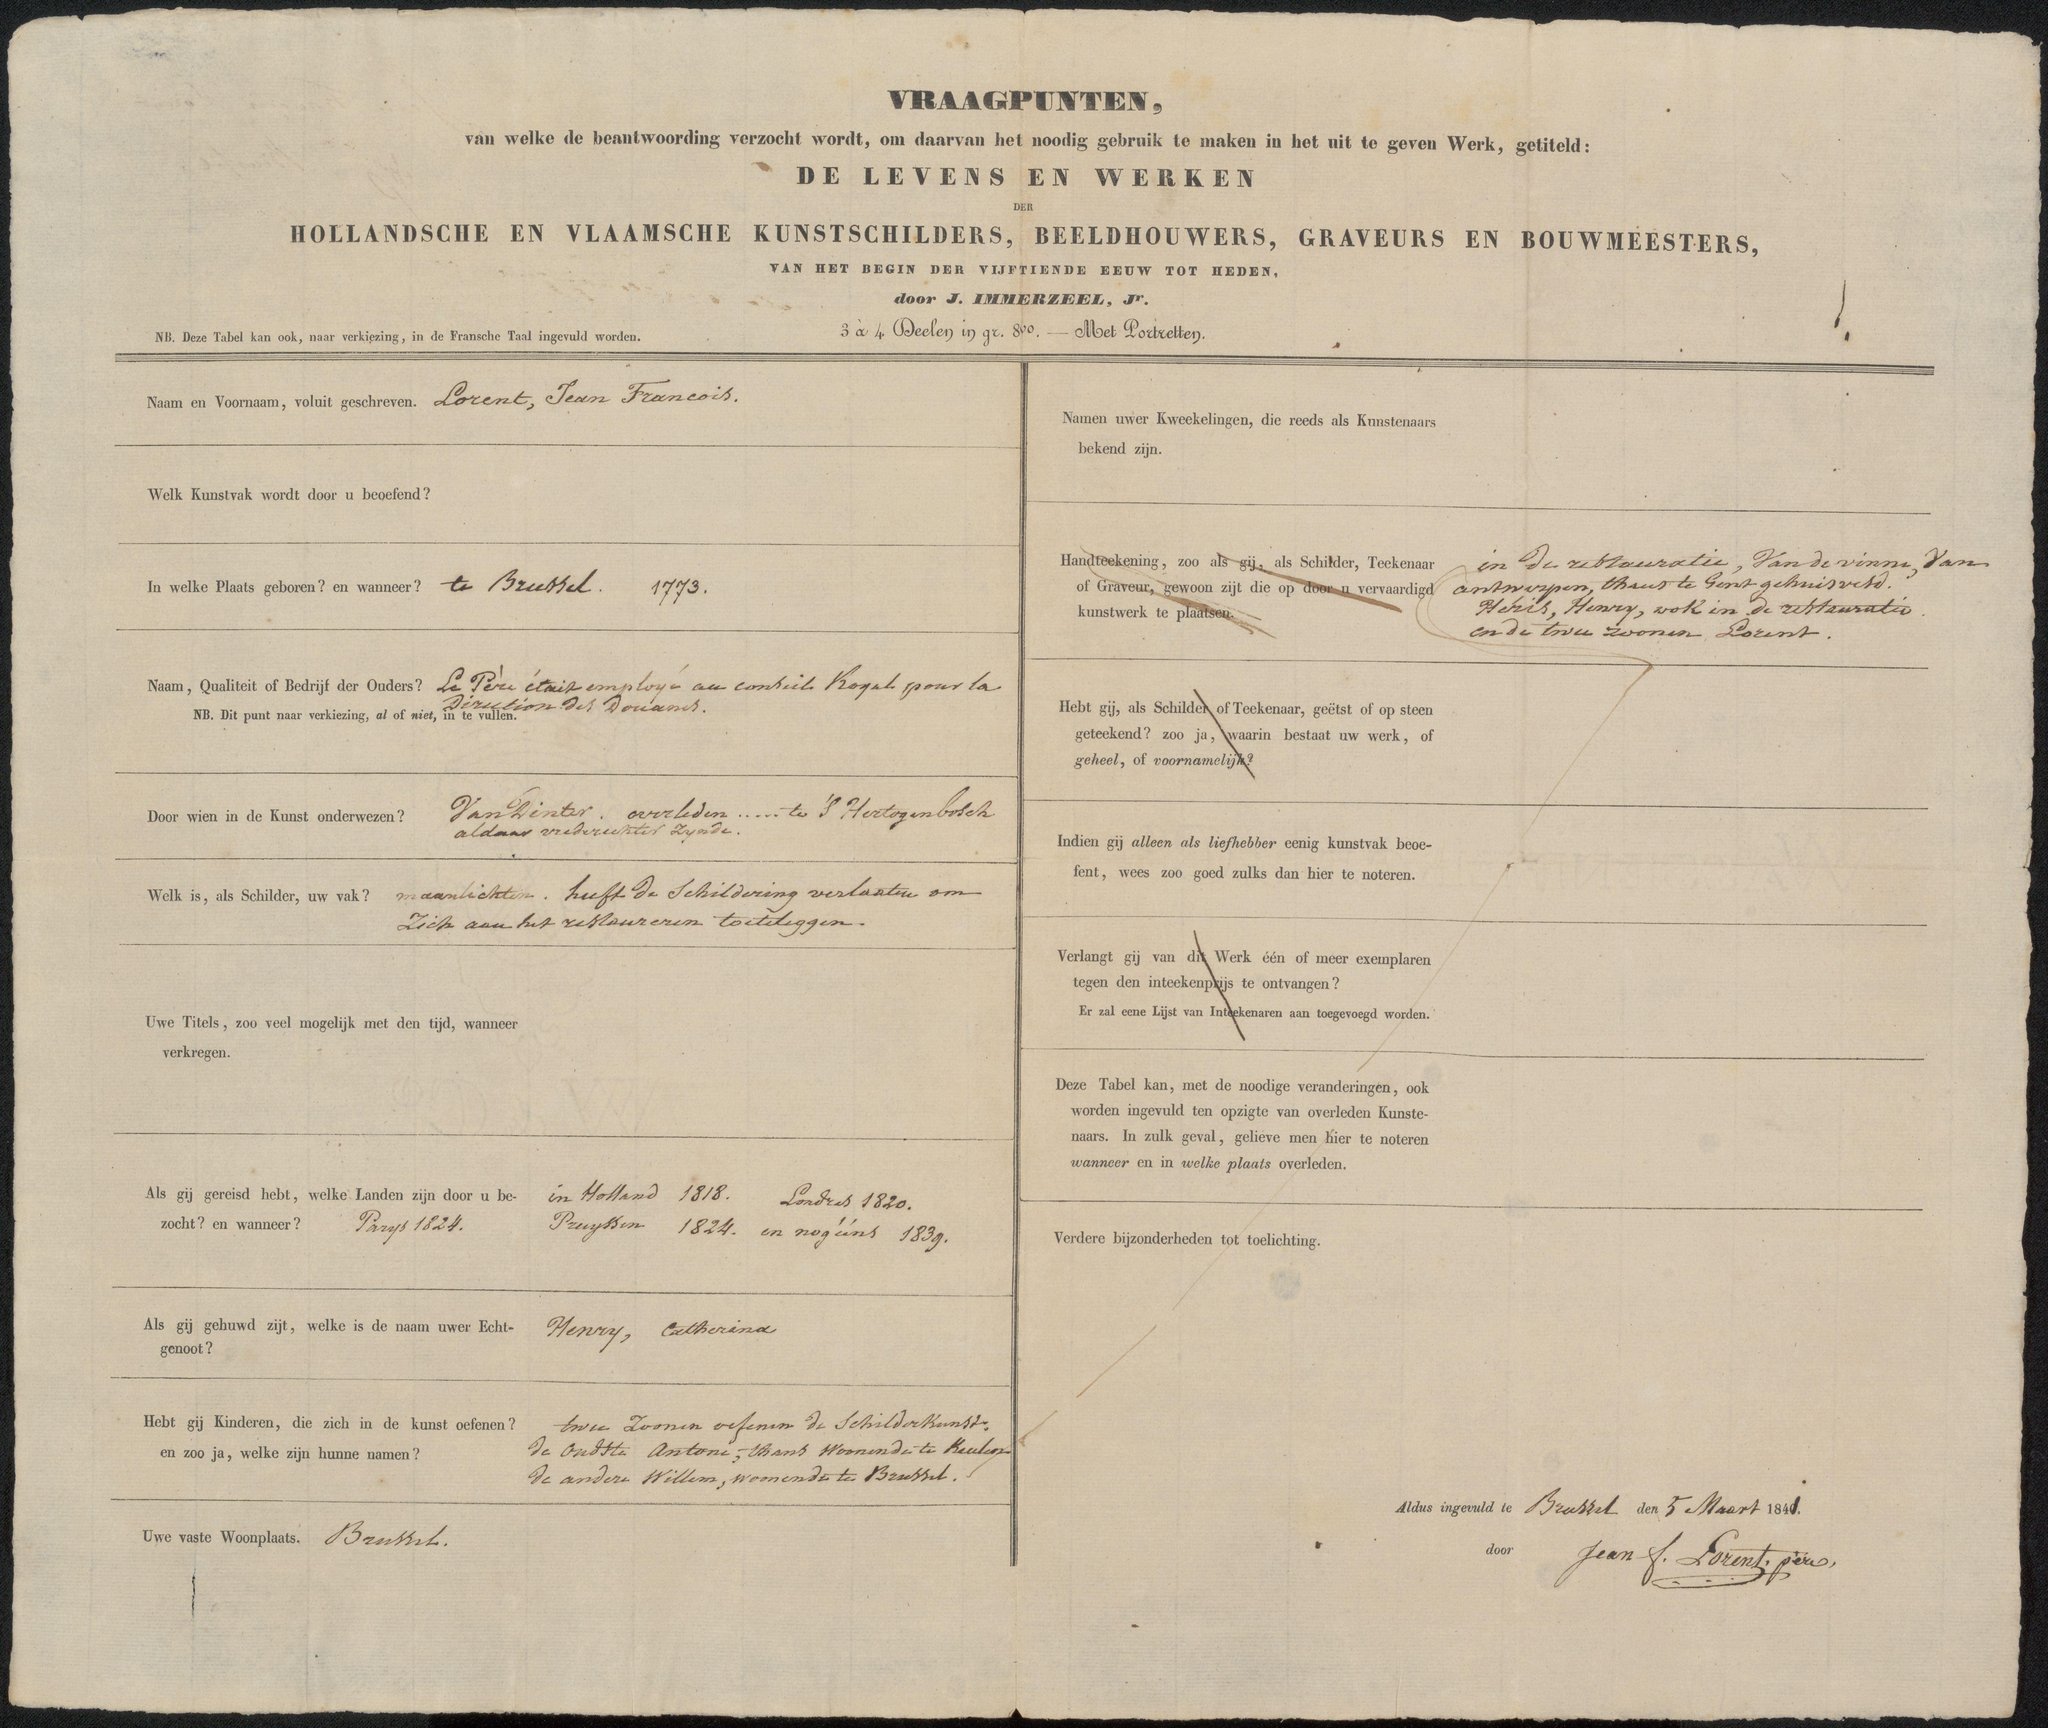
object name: manuscript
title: Enquêteformulier ingevuld door Jean-François Lorent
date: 1841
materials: ink, paper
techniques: pen, printing, writing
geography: brussels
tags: brussels, painter, draughtsman, jean-françois lorent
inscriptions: watermark, inscription: ‘Vraagpunten,/ van welke de beantwoording verzocht wordt, om daarvan het noodig gebruik te maken in het uit te geven Werk, getiteld: De levens en werken/ der Hollandsche en Vlaamsche kunstschilders, beeldhouwers,/ graveurs en bouwmeesters, van het begin der vijftiende eeuw tot heden/ door J. Immerzeel, Jr.’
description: Opgenomen in: Immerzeel, J. Jr., De levens en werken der Hollandsche en Vlaamsche kunstschilders, beeldhouwers, graveurs en bouwmeesters, van het begin der vijftiende eeuw tot heden, Amsterdam: J.C. van Kesteren, 1842-1843.